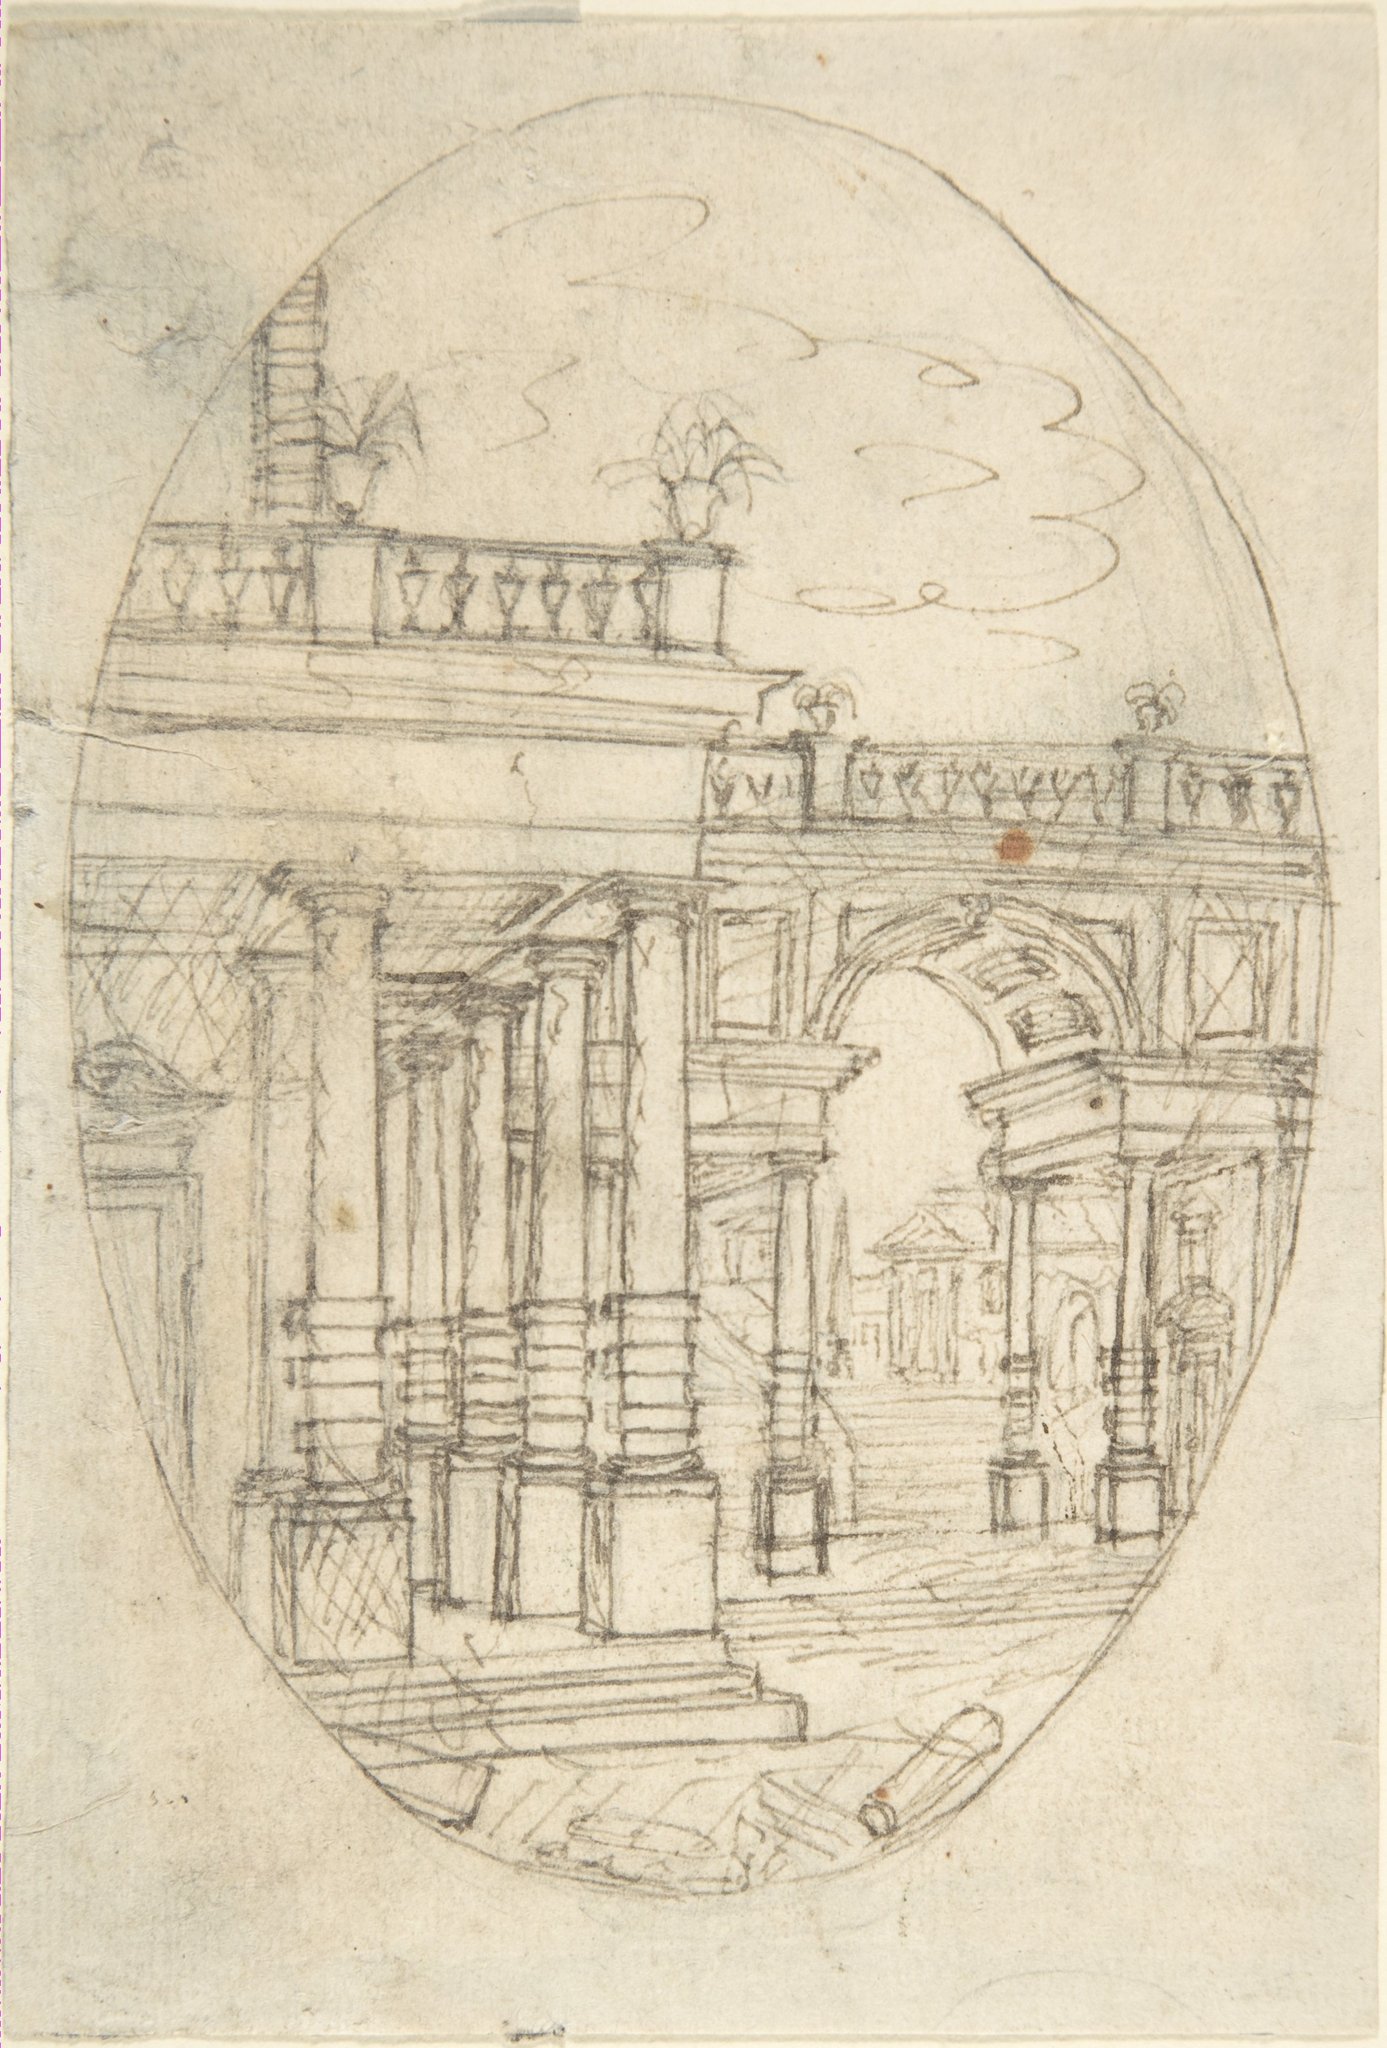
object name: drawing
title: Architectural Drawing (recto); Sketch of a Figure (verso)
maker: anonymous, italian, 18th century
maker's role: artist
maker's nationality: italian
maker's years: 1700-1800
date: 1701-1800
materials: chalk, graphite, ink, paper, lead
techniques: pen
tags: architecture,buildings,columns